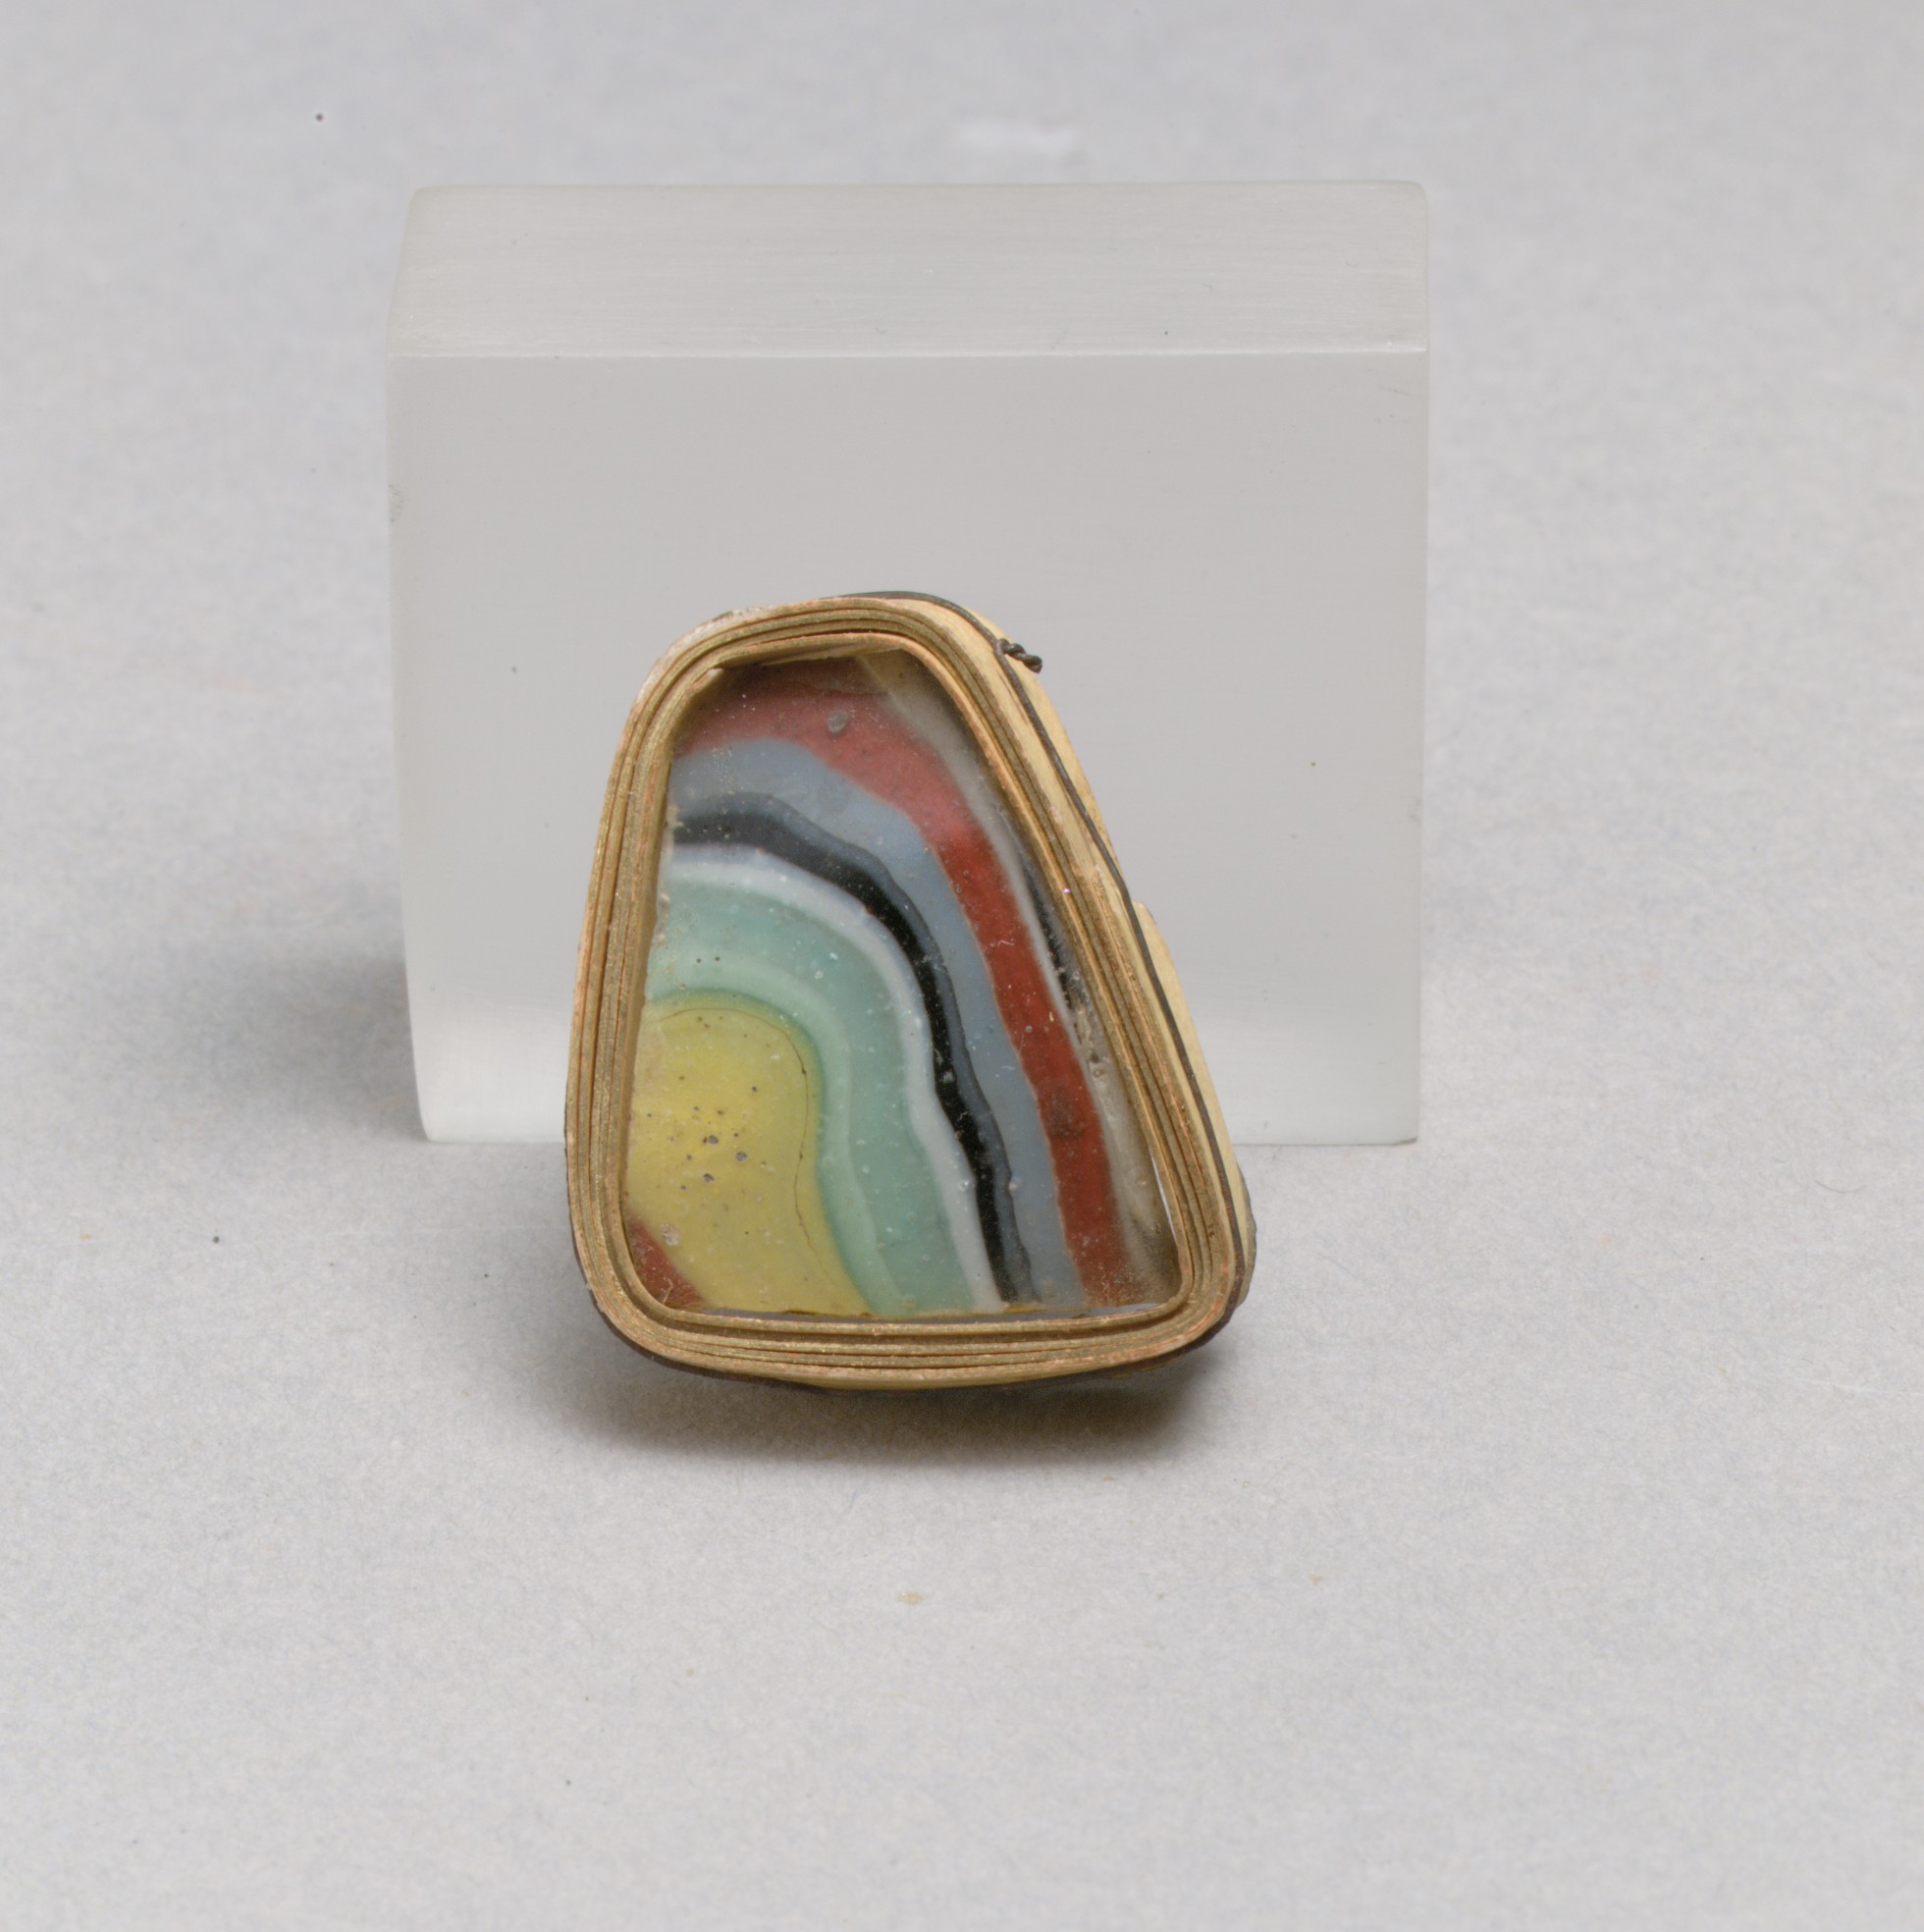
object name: fragment, mosaic bowl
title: Glass striped mosaic bowl fragment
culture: roman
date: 34 BCE-33 CE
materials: glass